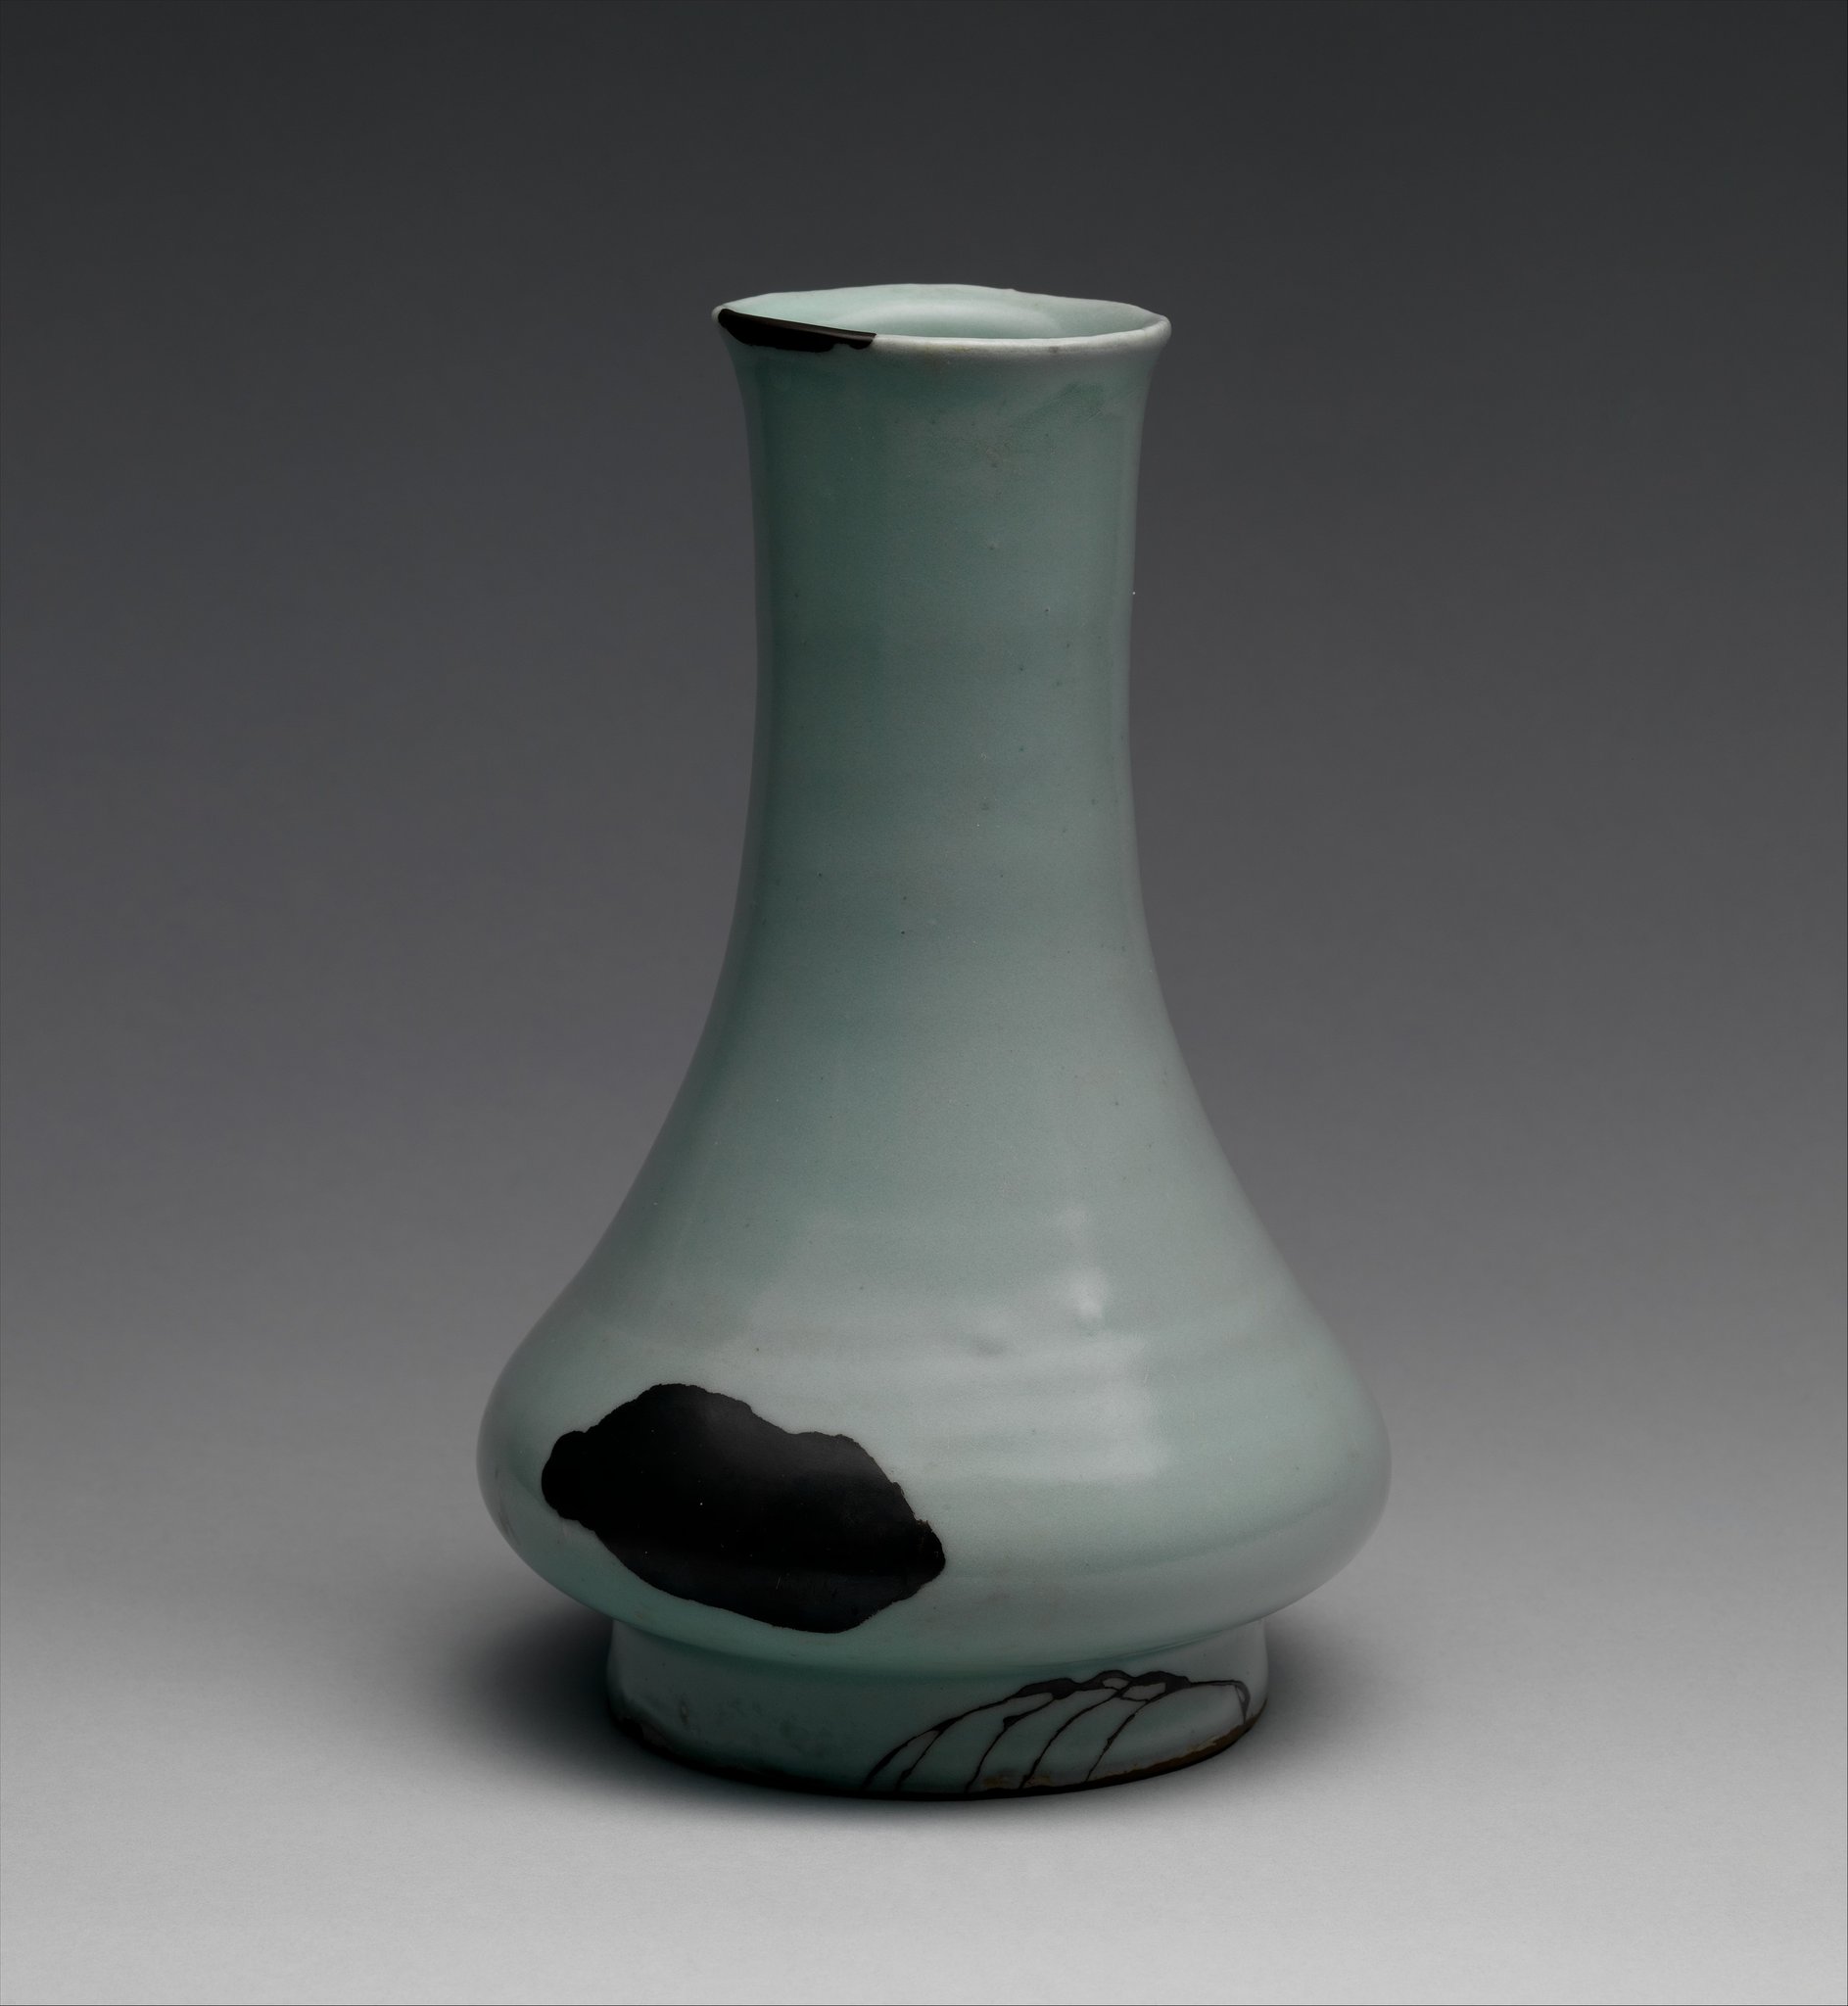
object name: vase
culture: chinese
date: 1101-1200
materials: glaze, stoneware